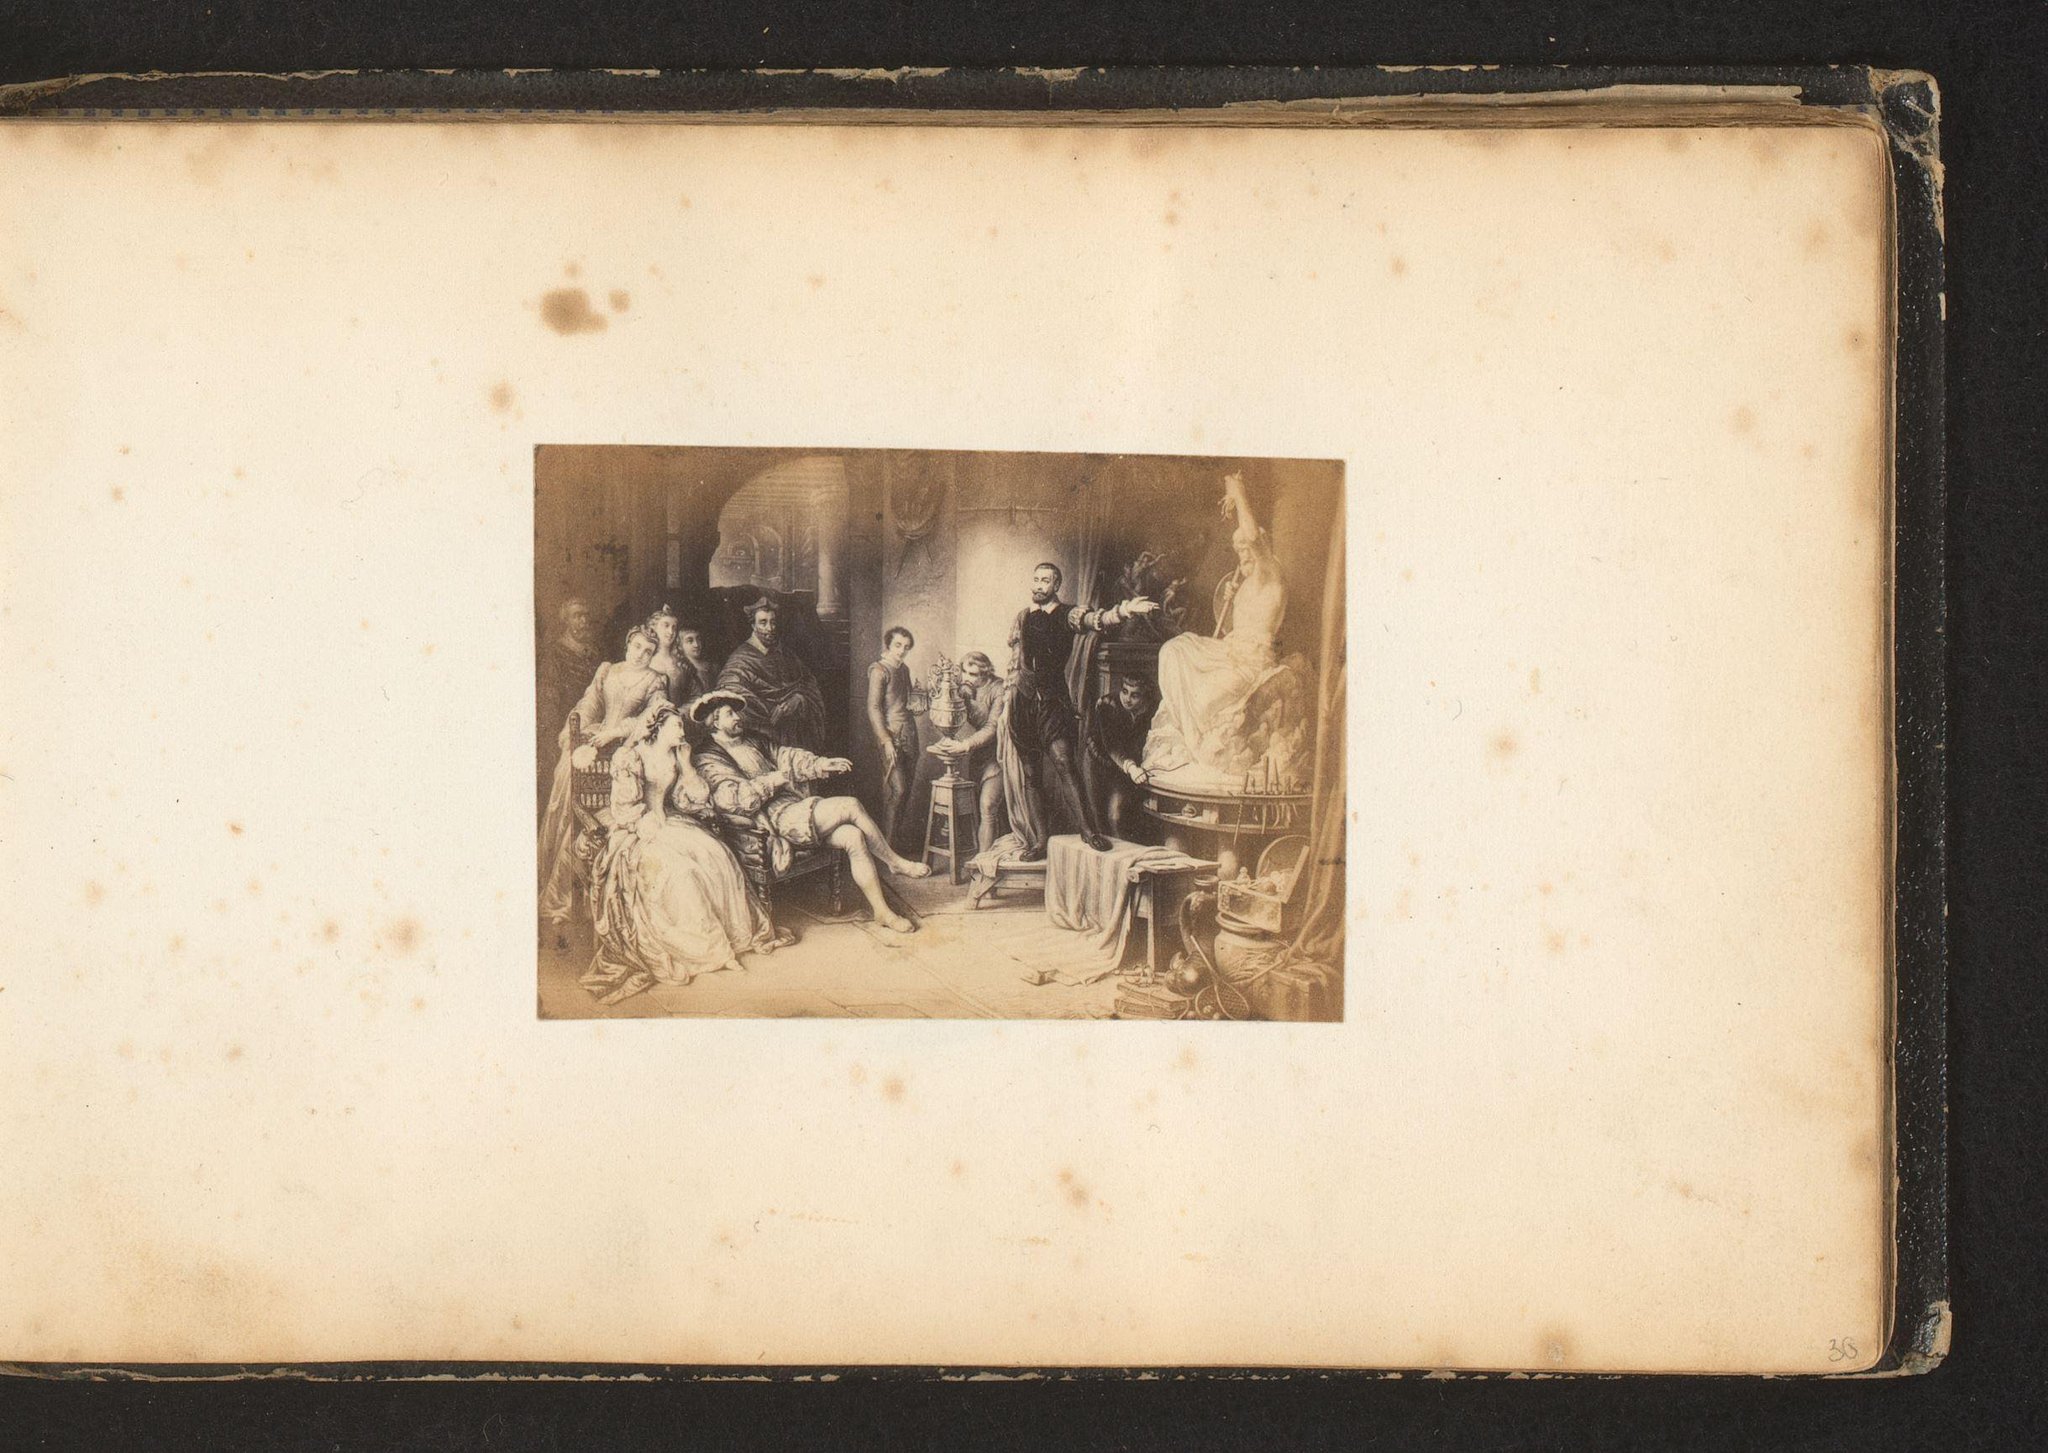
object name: photograph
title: Fotoreproductie van een schilderij van de onthulling van een sculptuur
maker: Anonymous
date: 1860-1900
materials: photographic support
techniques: albumen print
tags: adult woman, adult man, monument, statue, painting, drawing and the graphic arts